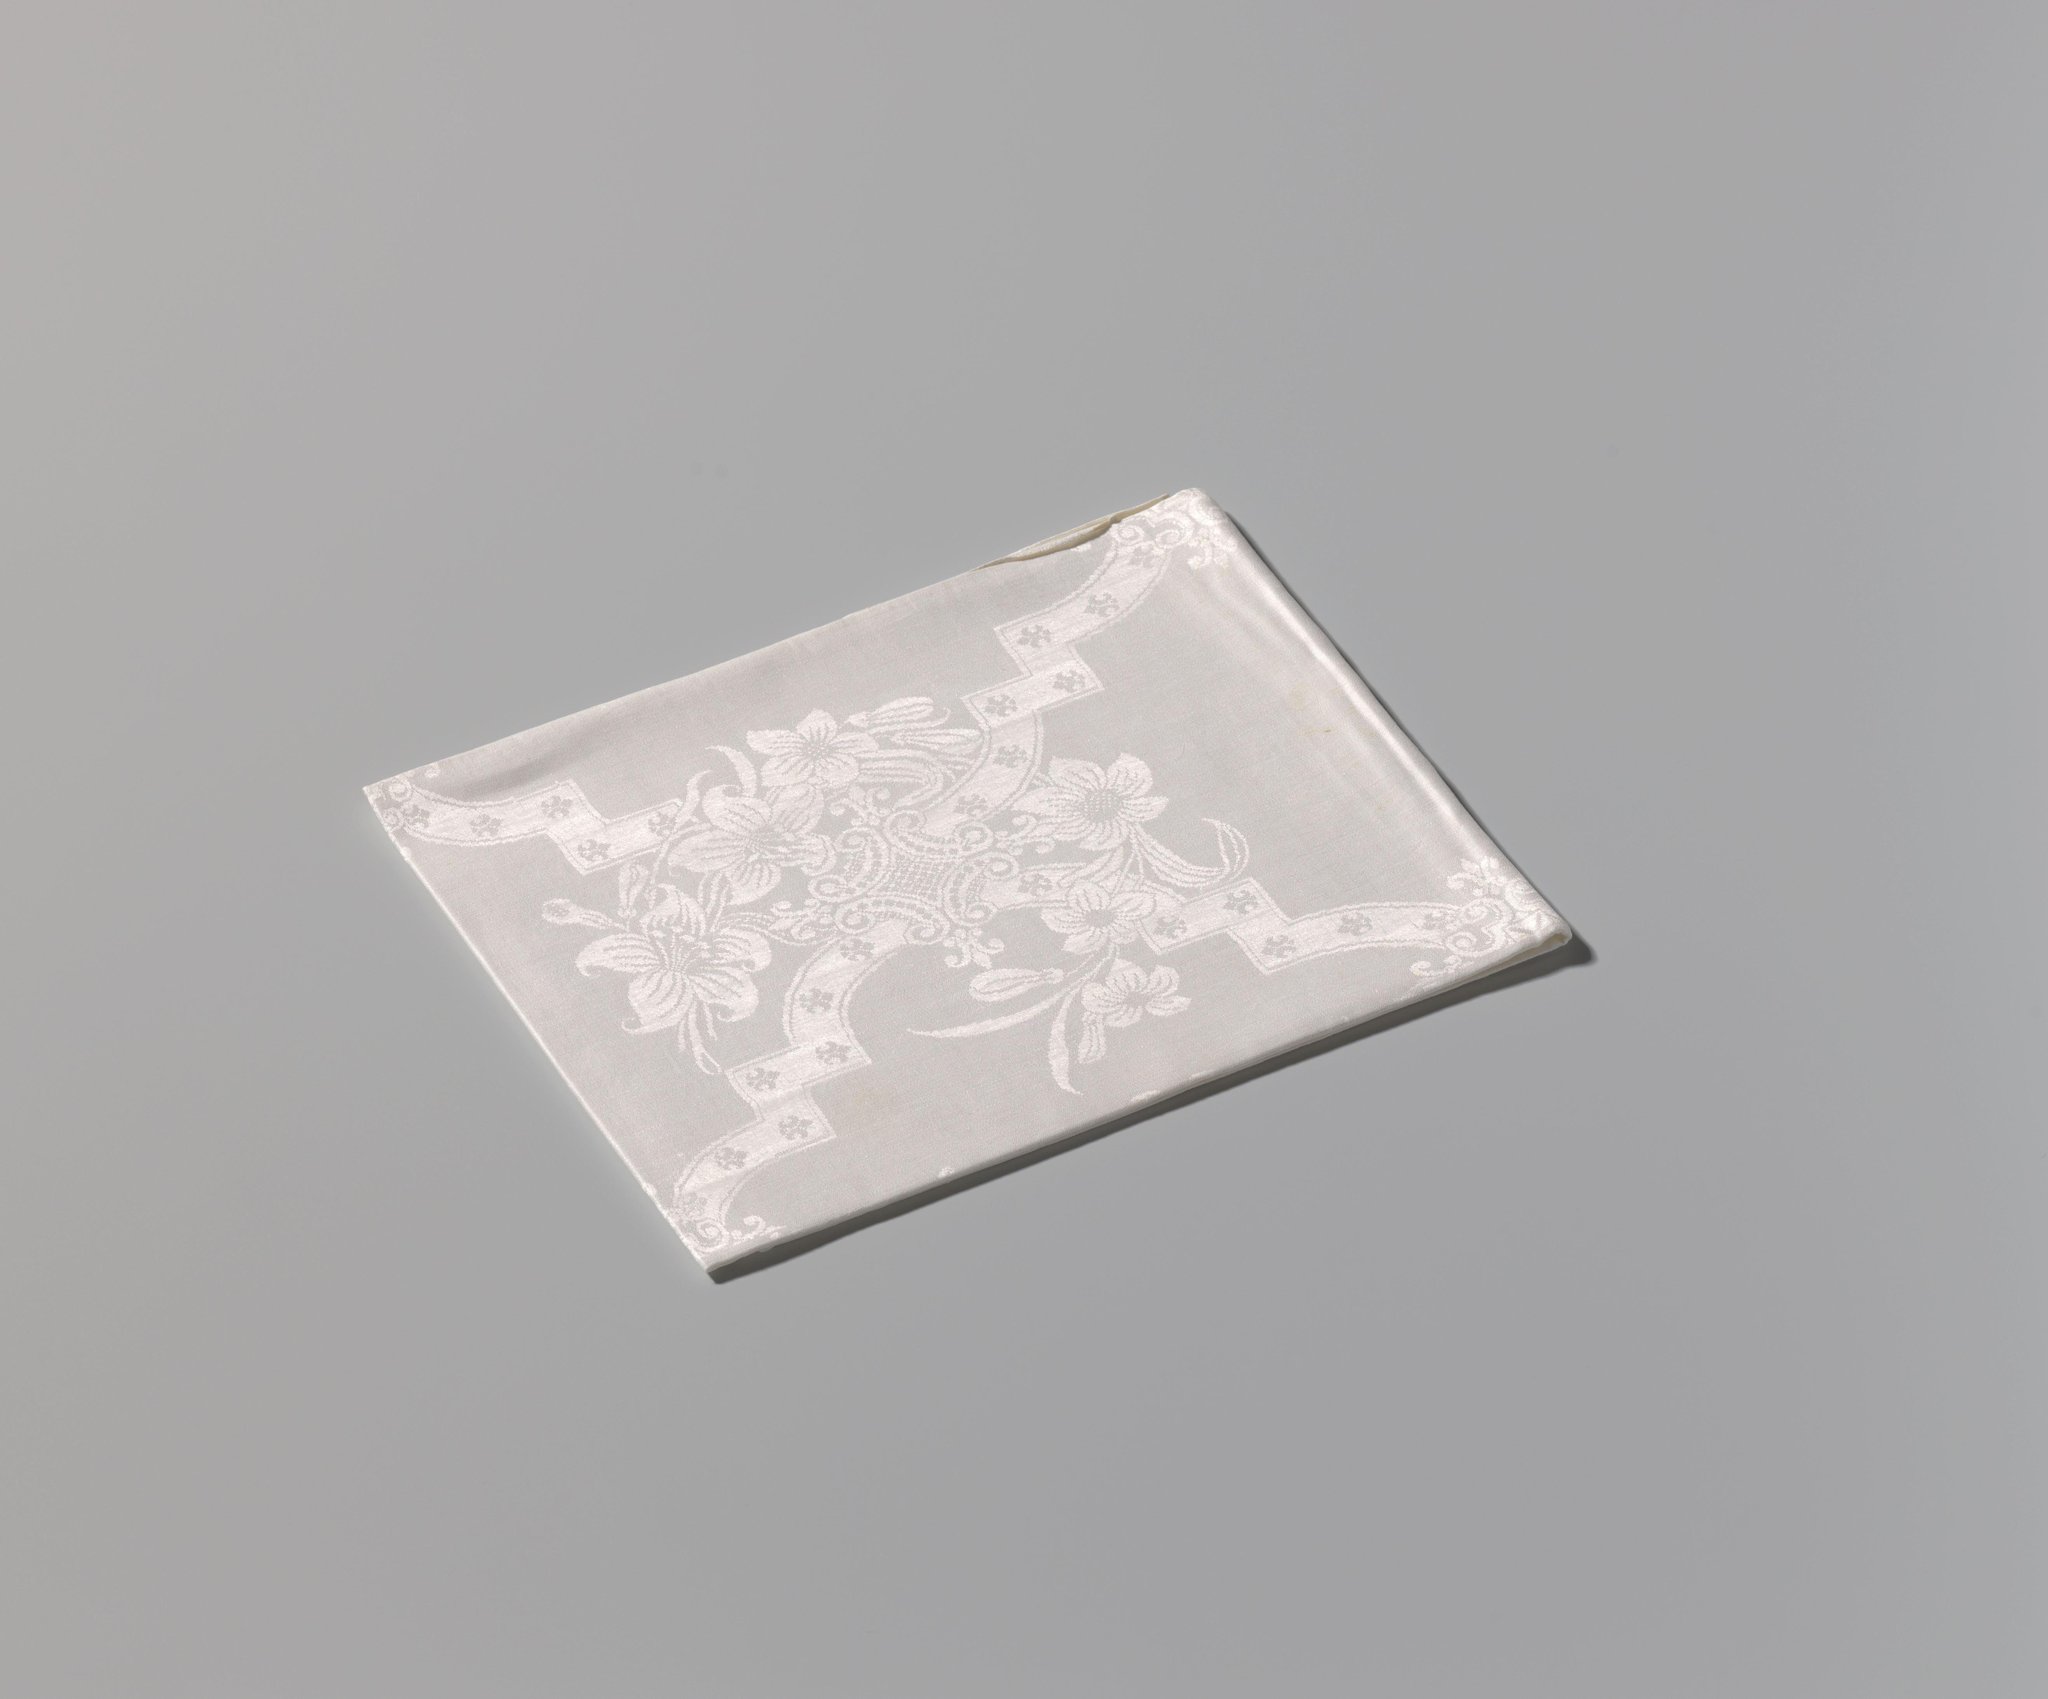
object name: napkin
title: Servet met fleurs de lys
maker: Anonymous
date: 1700-1710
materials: linen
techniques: damask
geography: dresden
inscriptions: mark: ‘BLS’, label: ‘R.M.A'dam’, mark: ‘24’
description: Servet van linnendamast met fleurs de lys. Slingerende banden vormen in de hoogte gerekte velden. De banden bestaan uit rechte en ronde delen, gevuld met kleine fleurs de lys; op de raakpunten een slingerende tak met leliën. De rand, alleen aan de buitenzijde omlijnd met fijne zigzagzomen en rolwerk met rastervulling, vertoont dicht aaneengesloten bloemboeketten, in de hoeken naar het midden gericht en voortkomend uit een draagstuk, waarop een fleur de lys. Rondom: blokkenrand.